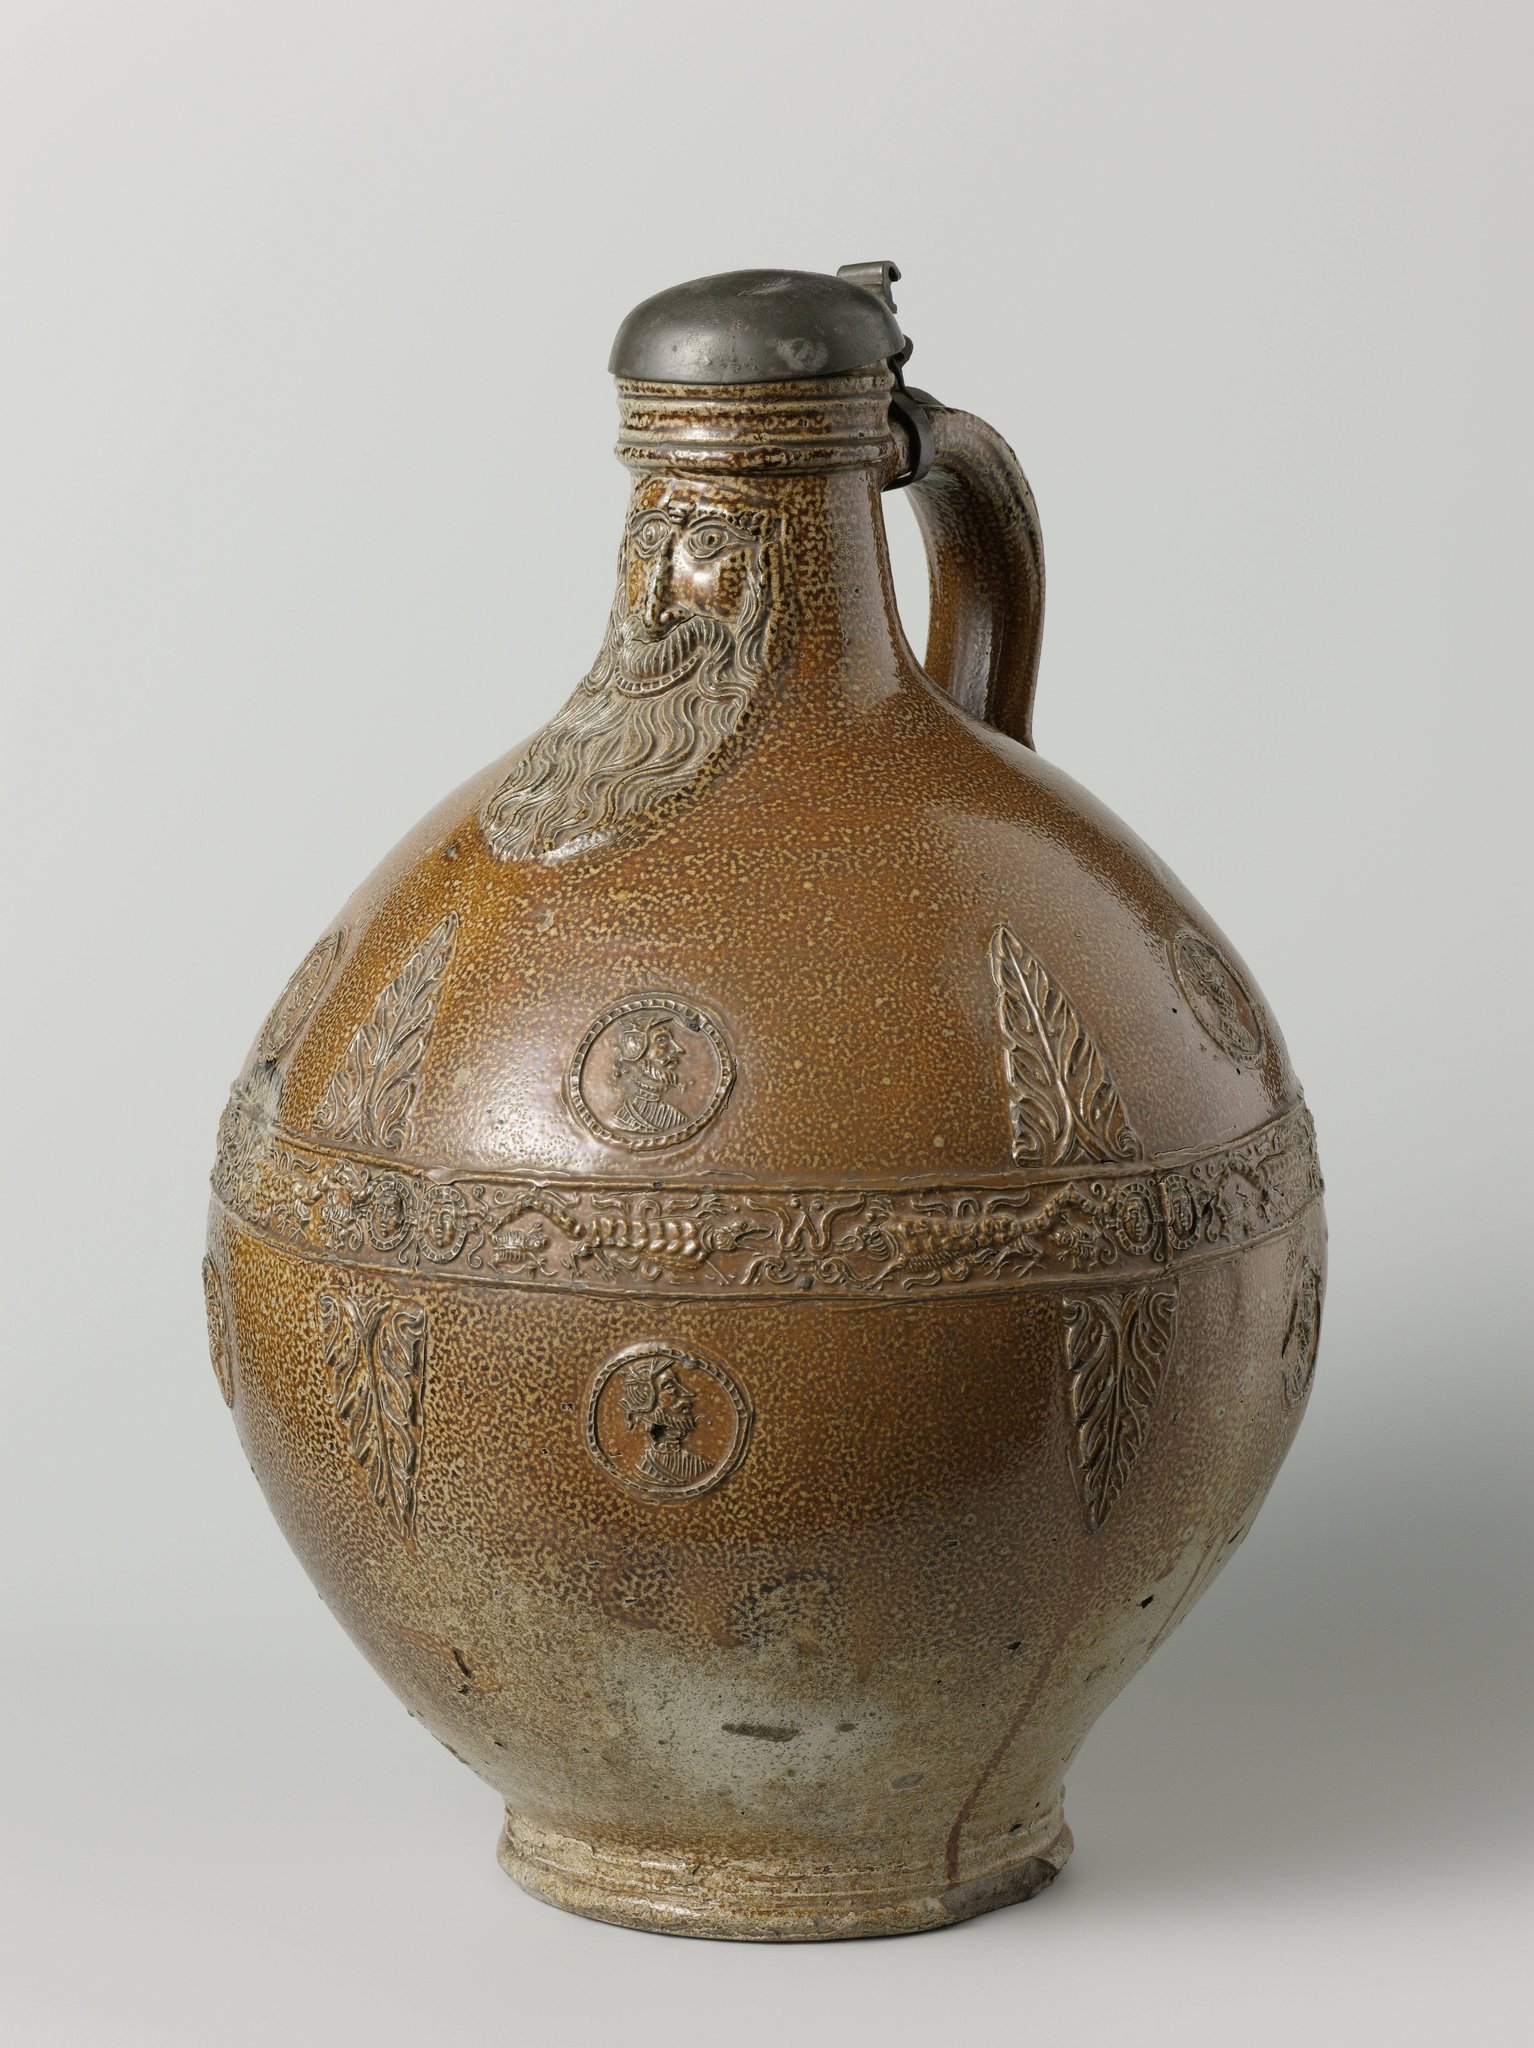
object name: jug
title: Jug (Bartmann jug) with portraits, leaves and an ornamental border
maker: Anonymous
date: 1550-1580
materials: engobe, glaze, stoneware, tin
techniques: firing, forming, relief, turning, vitrification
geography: cologne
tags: foliage, tendrils, branches ~ ornament, beard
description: Kruik (baardmankruik) van steengoed op hoge voet met een bolvormig lichaam en smalle nek. Het C-vormige oor is bevestigd aan de nek en de schouder. Profielen op de nek en voet. Bedekt met een bruine engobe. Op de buik in reliëf een gedrukte en opgelegde decoratieve band met maskers in medaillons en schorpioenen. Aan weerszijden van het opschrift medaillons met portretten en profil en bladmotieven. Op de nek, doorlopend op de schouder, een baardman. Bevestigd aan het oor een tinnen montuur met deksel. Keulen/ Frechen.